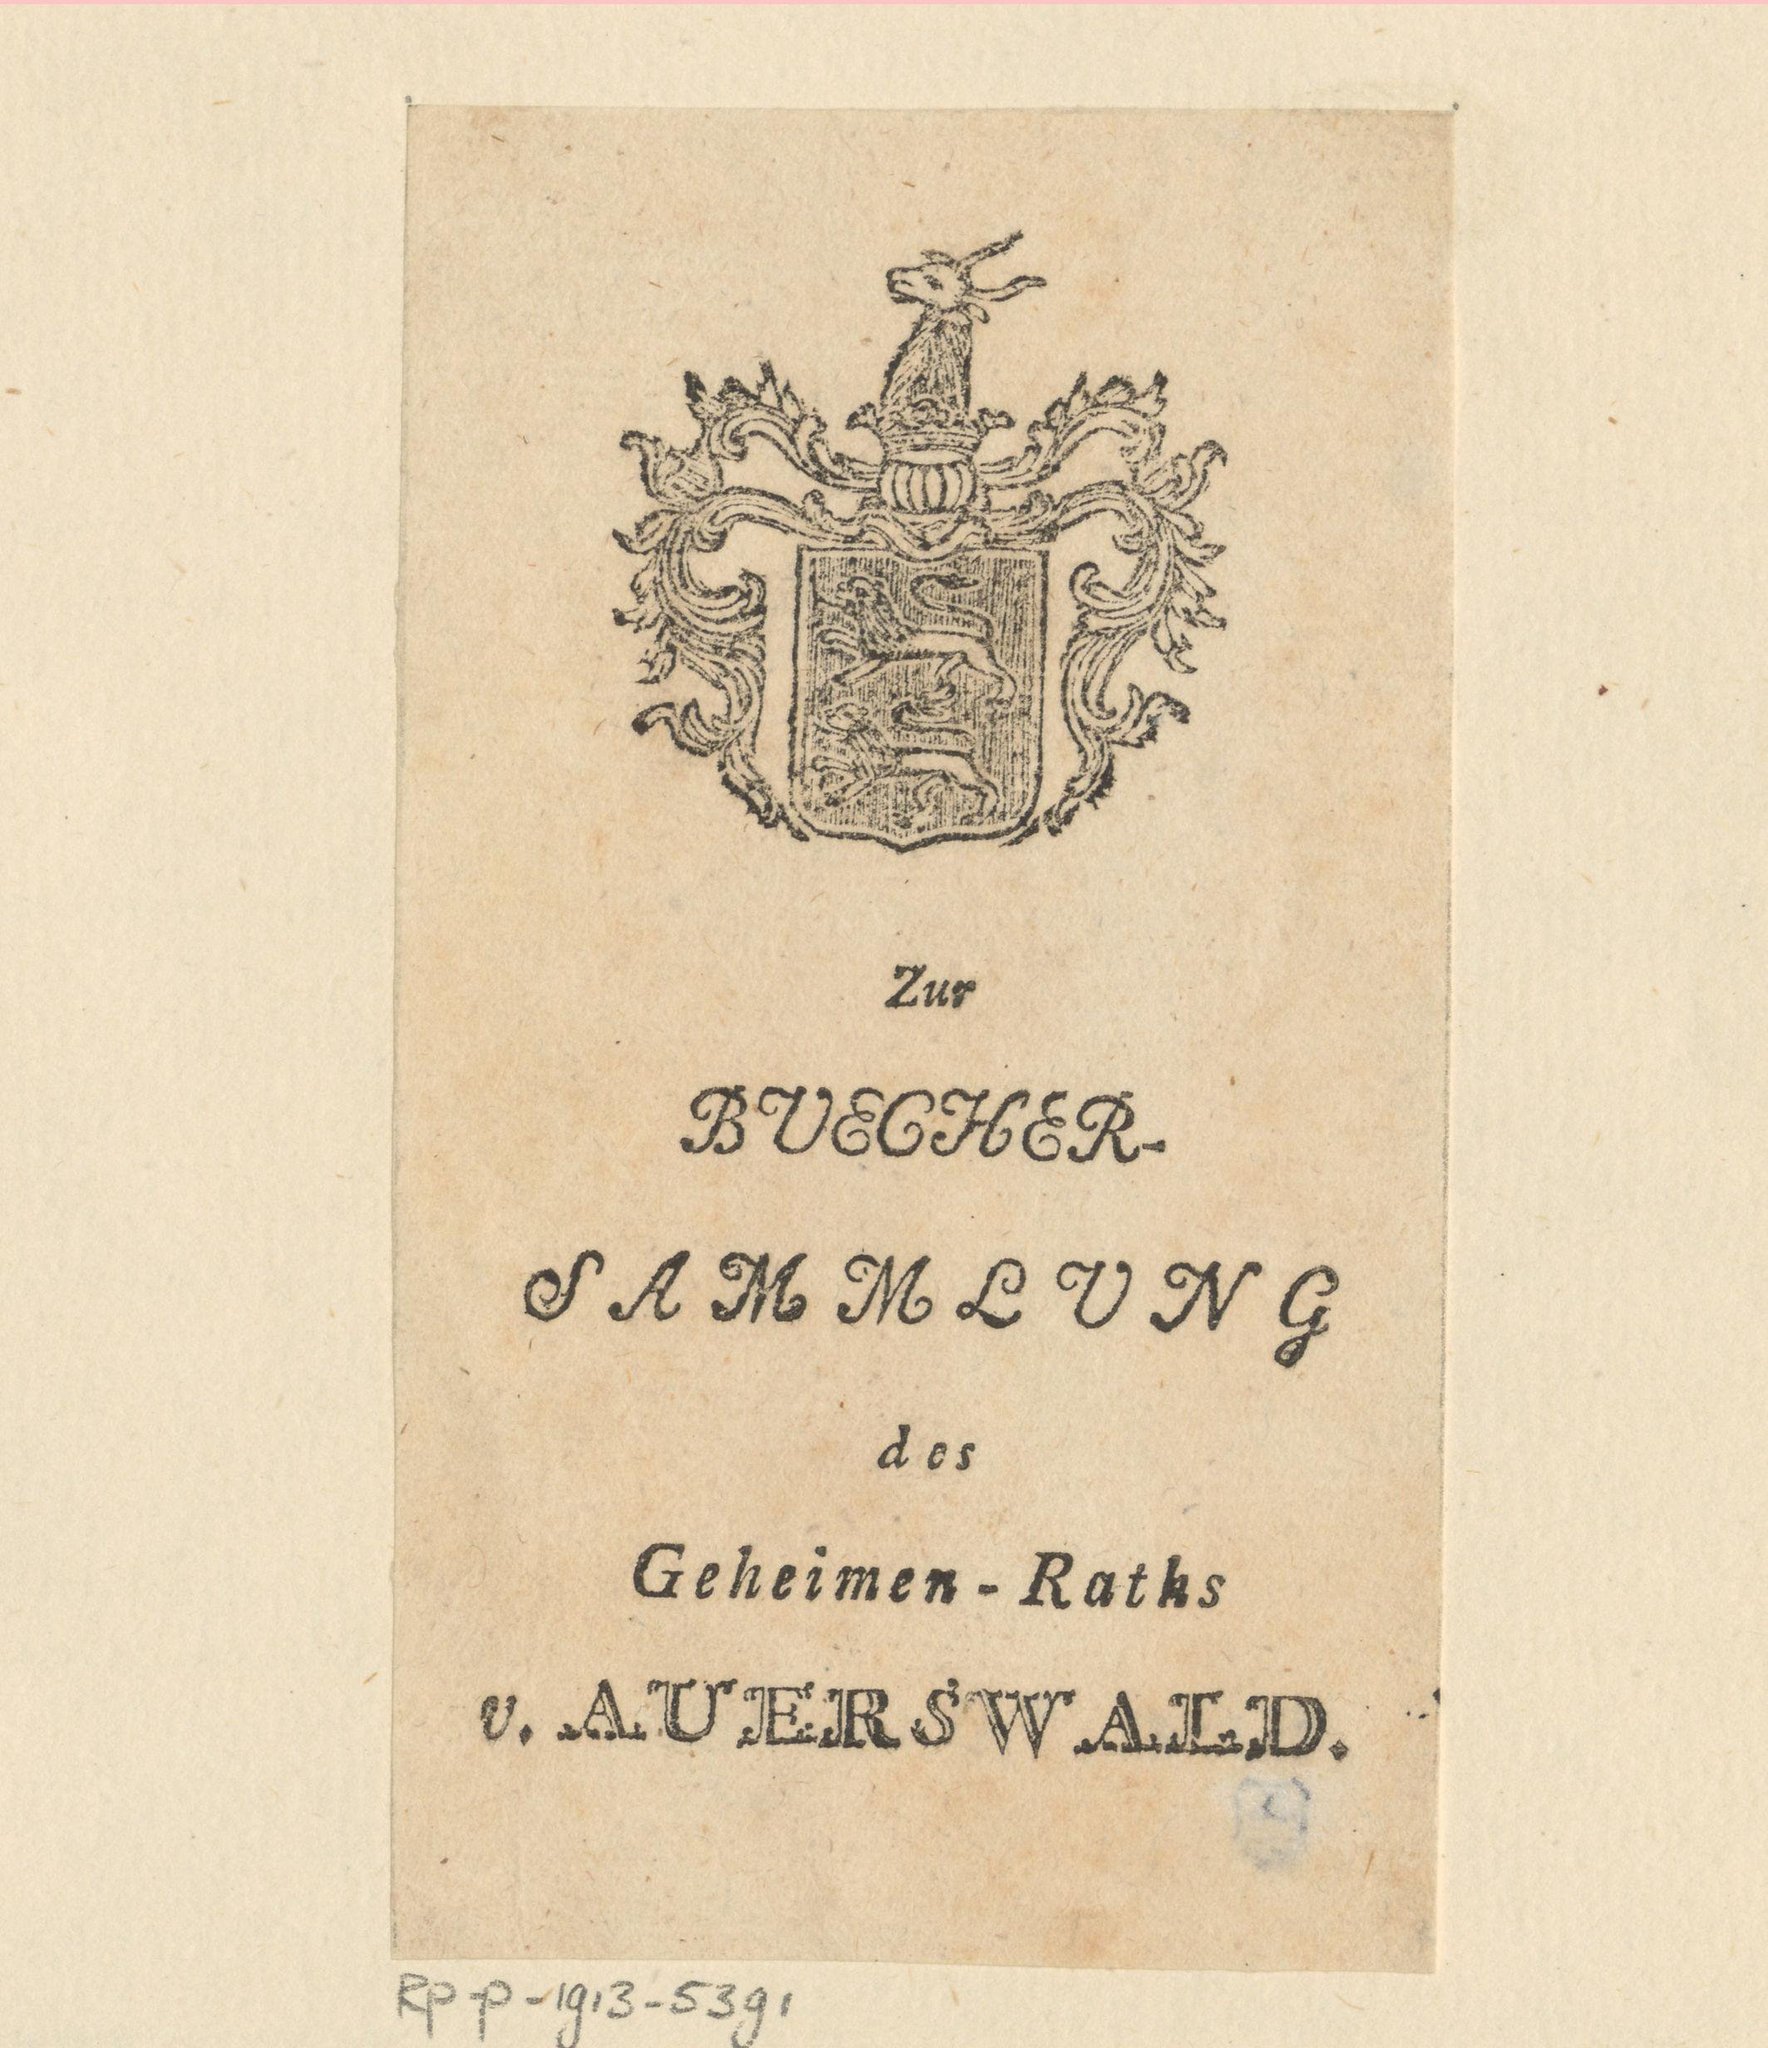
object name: bookplate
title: Ex libris van Zur Buechersammlung des Geheimen-Raths v. Auerswald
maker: Anonymous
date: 1700-1799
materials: paper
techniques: woodcut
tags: armorial bearing, heraldry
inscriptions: collector's mark: Lugt 2233, collector's mark: Lugt 2760